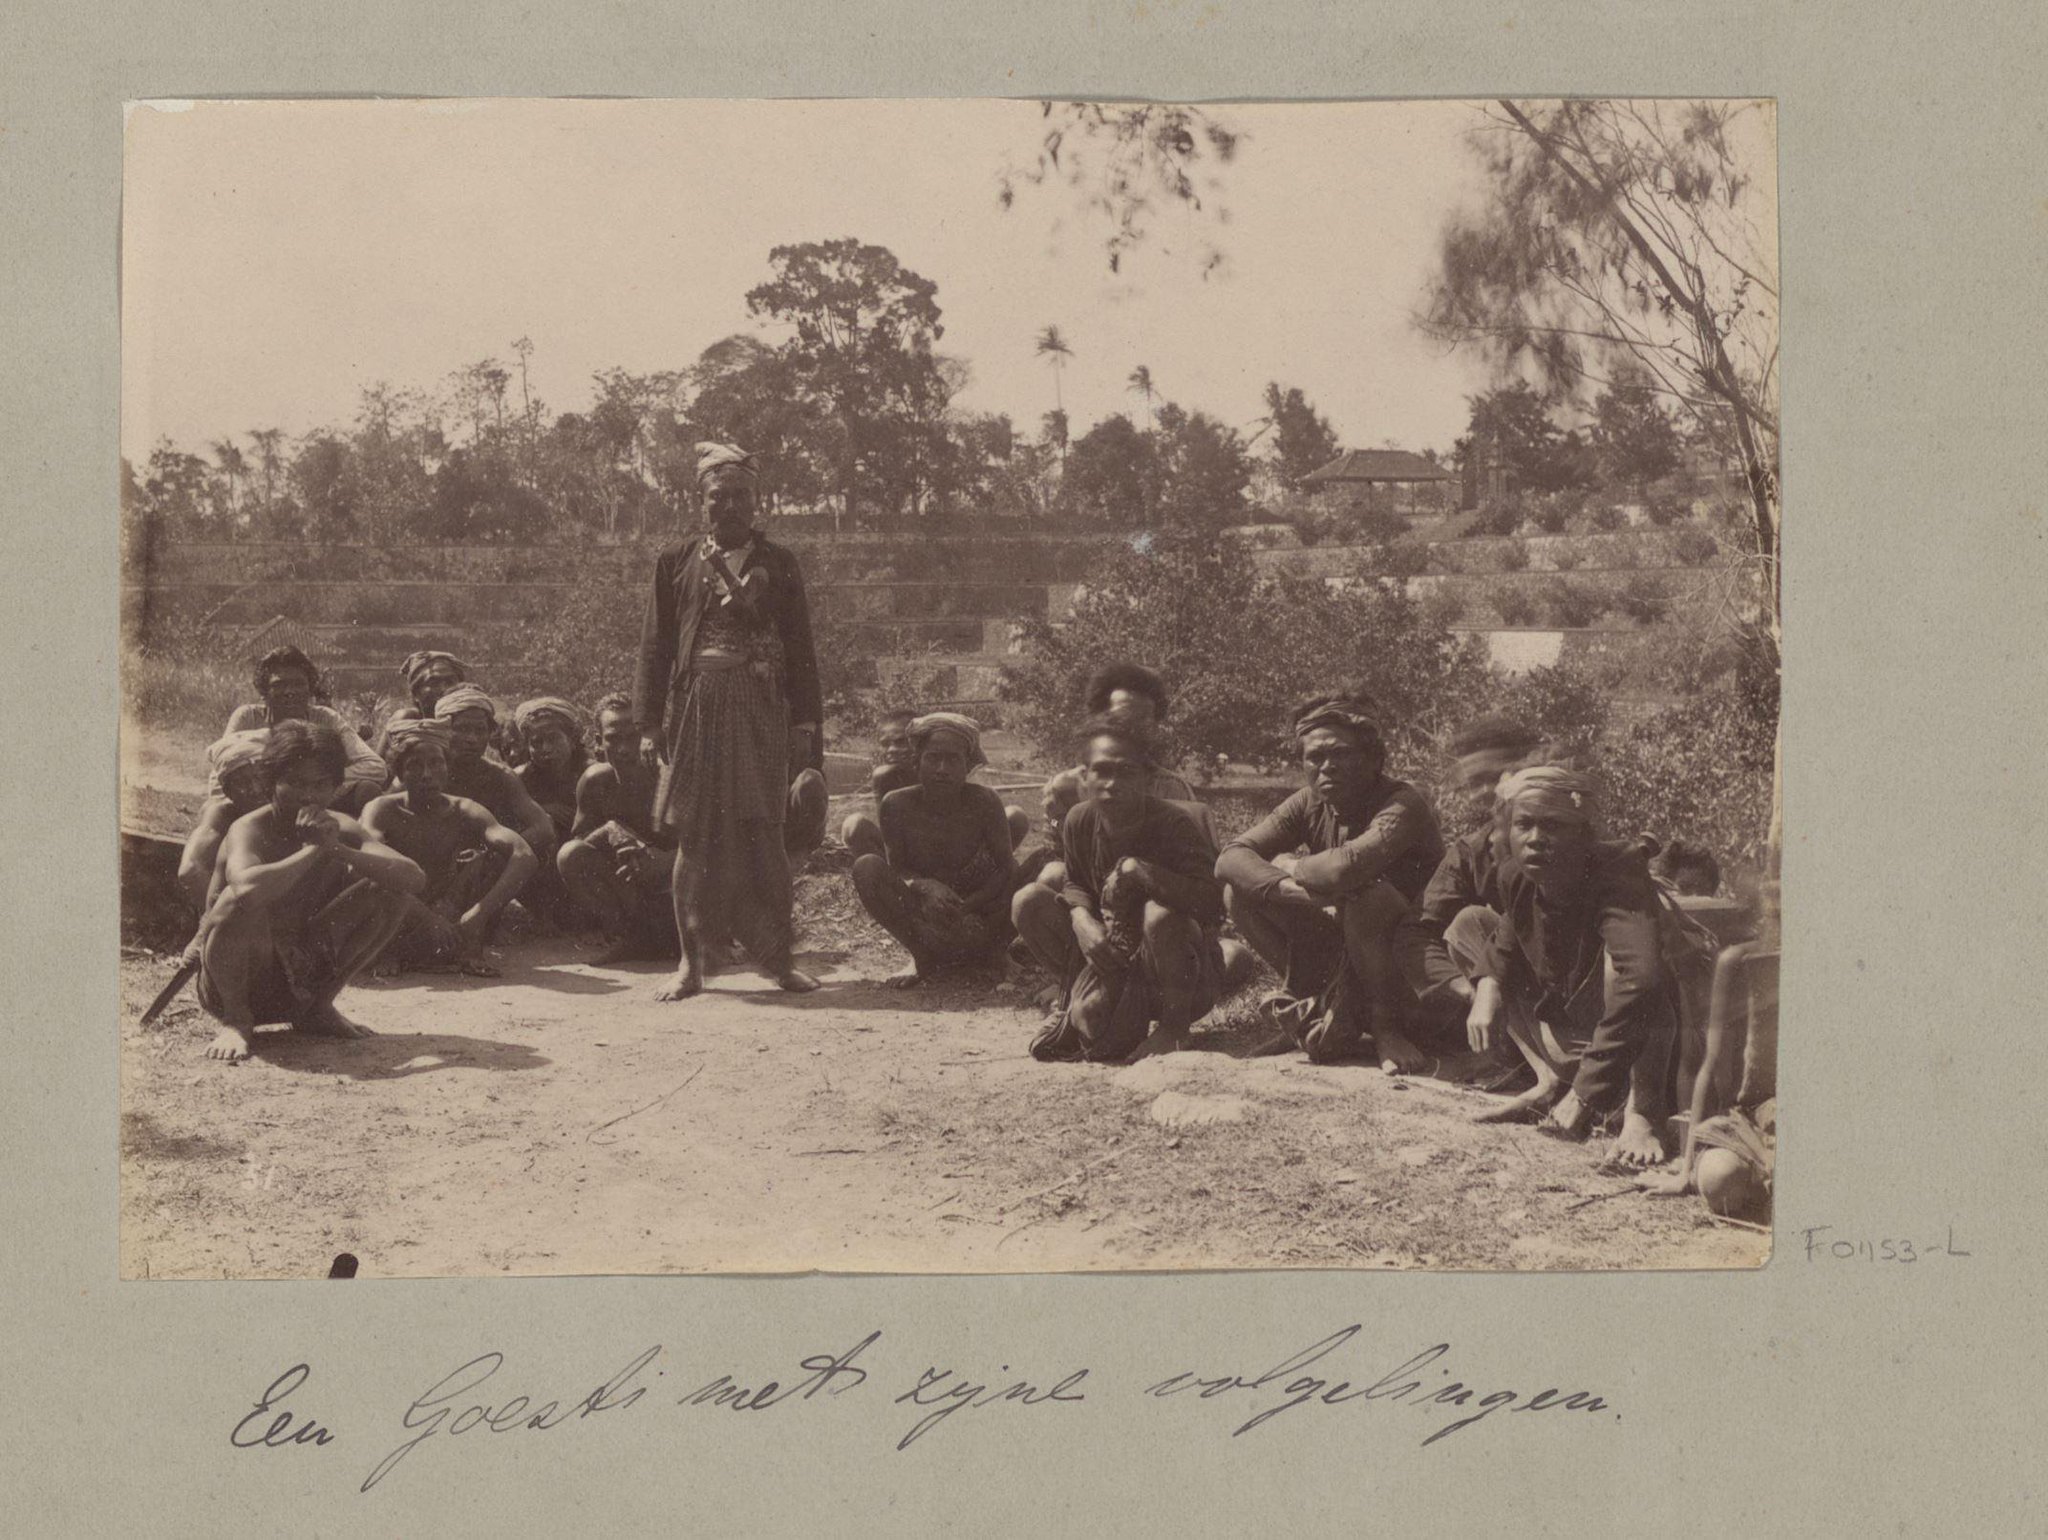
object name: photograph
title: Een Goesti met zijne volgelingen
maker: christiaan johan neeb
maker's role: arts, fotograaf, officier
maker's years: 1860-1925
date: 1894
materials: photographic support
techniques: albumen print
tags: adult man, religious functionaries ~ hinduism, buddhism, jainism, dutch east indies, the, indonesia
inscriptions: number: ‘51.’